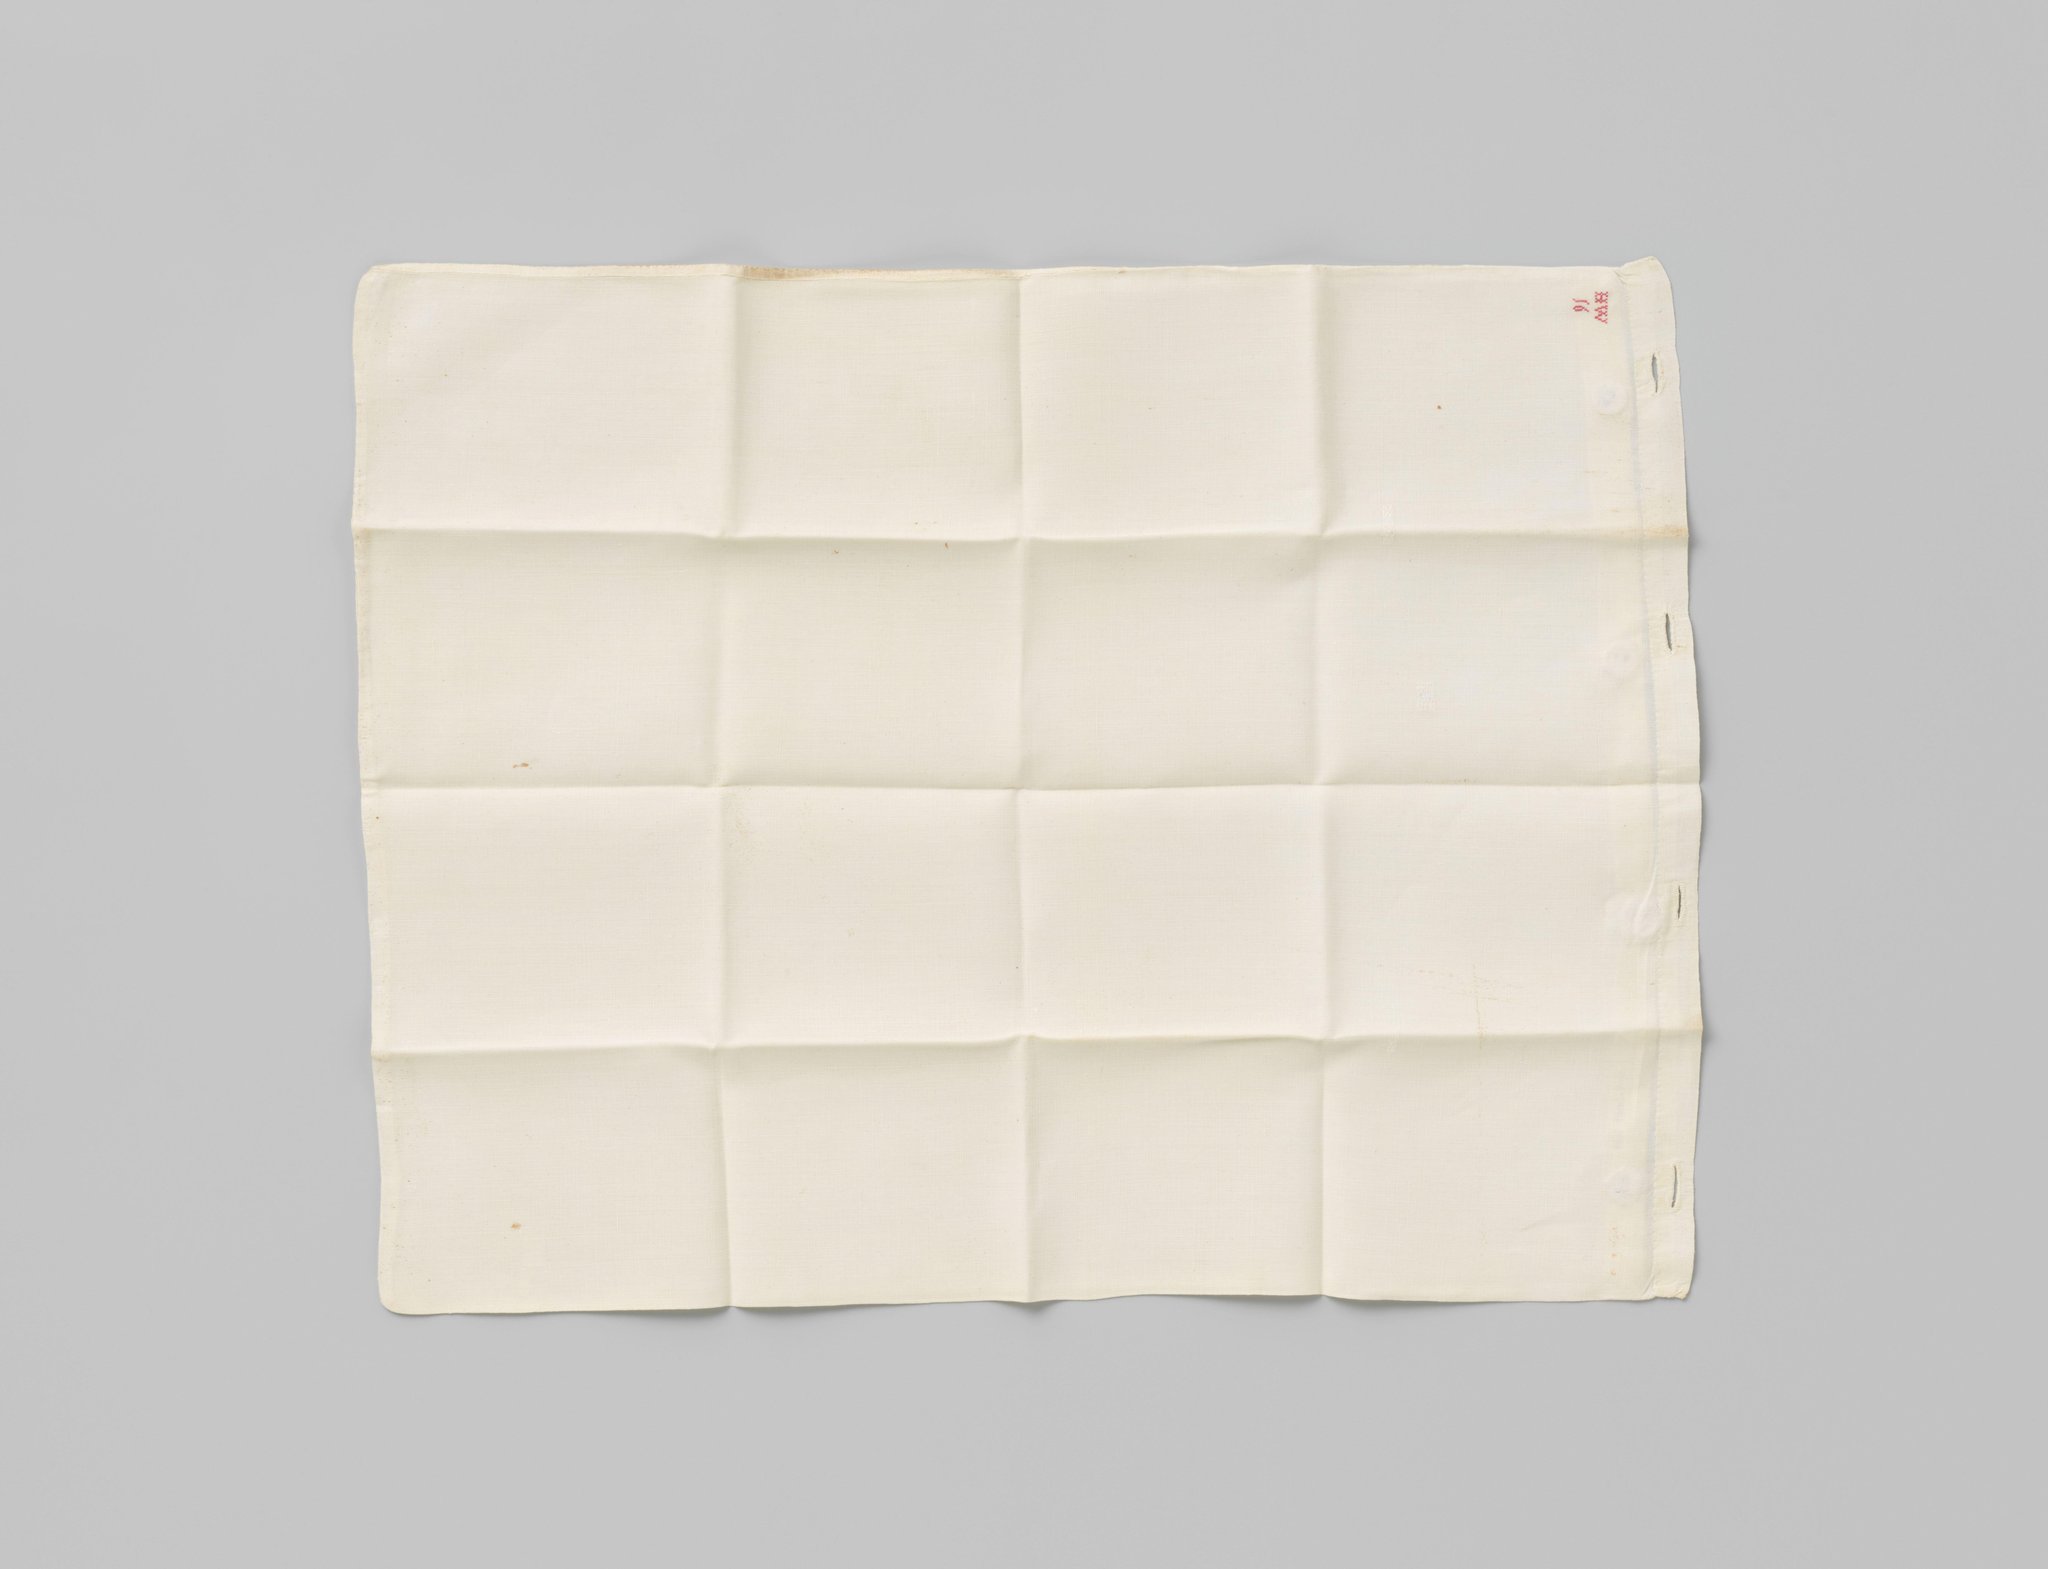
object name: lendensloop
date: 1852-1872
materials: linen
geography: northern netherlands